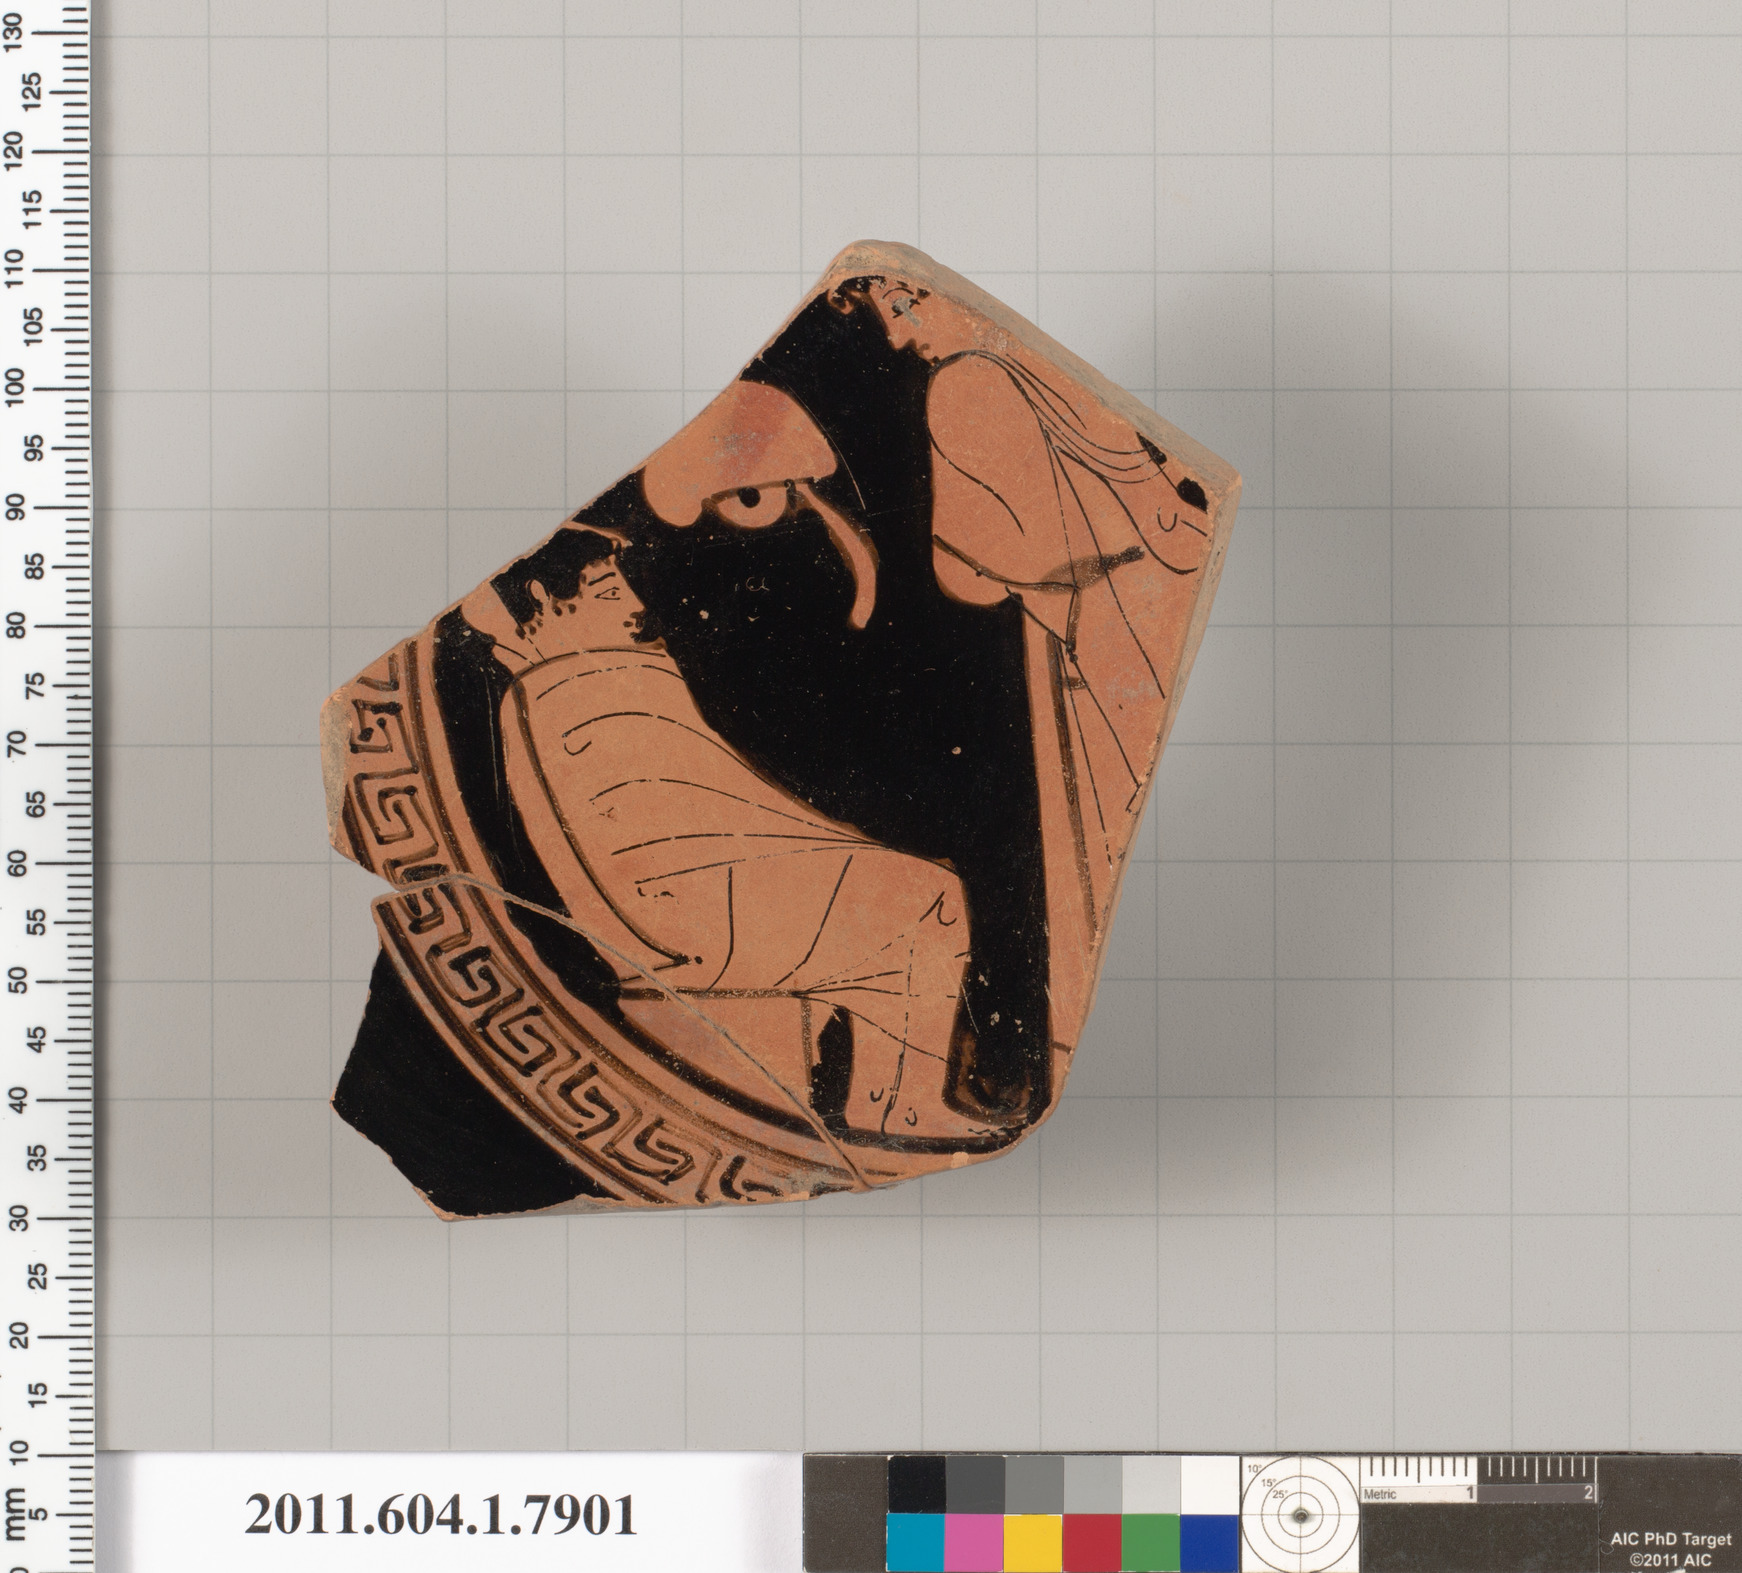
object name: kylix fragment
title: Terracotta fragment of a kylix (drinking cup)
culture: greek, attic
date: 450 BCE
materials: terracotta